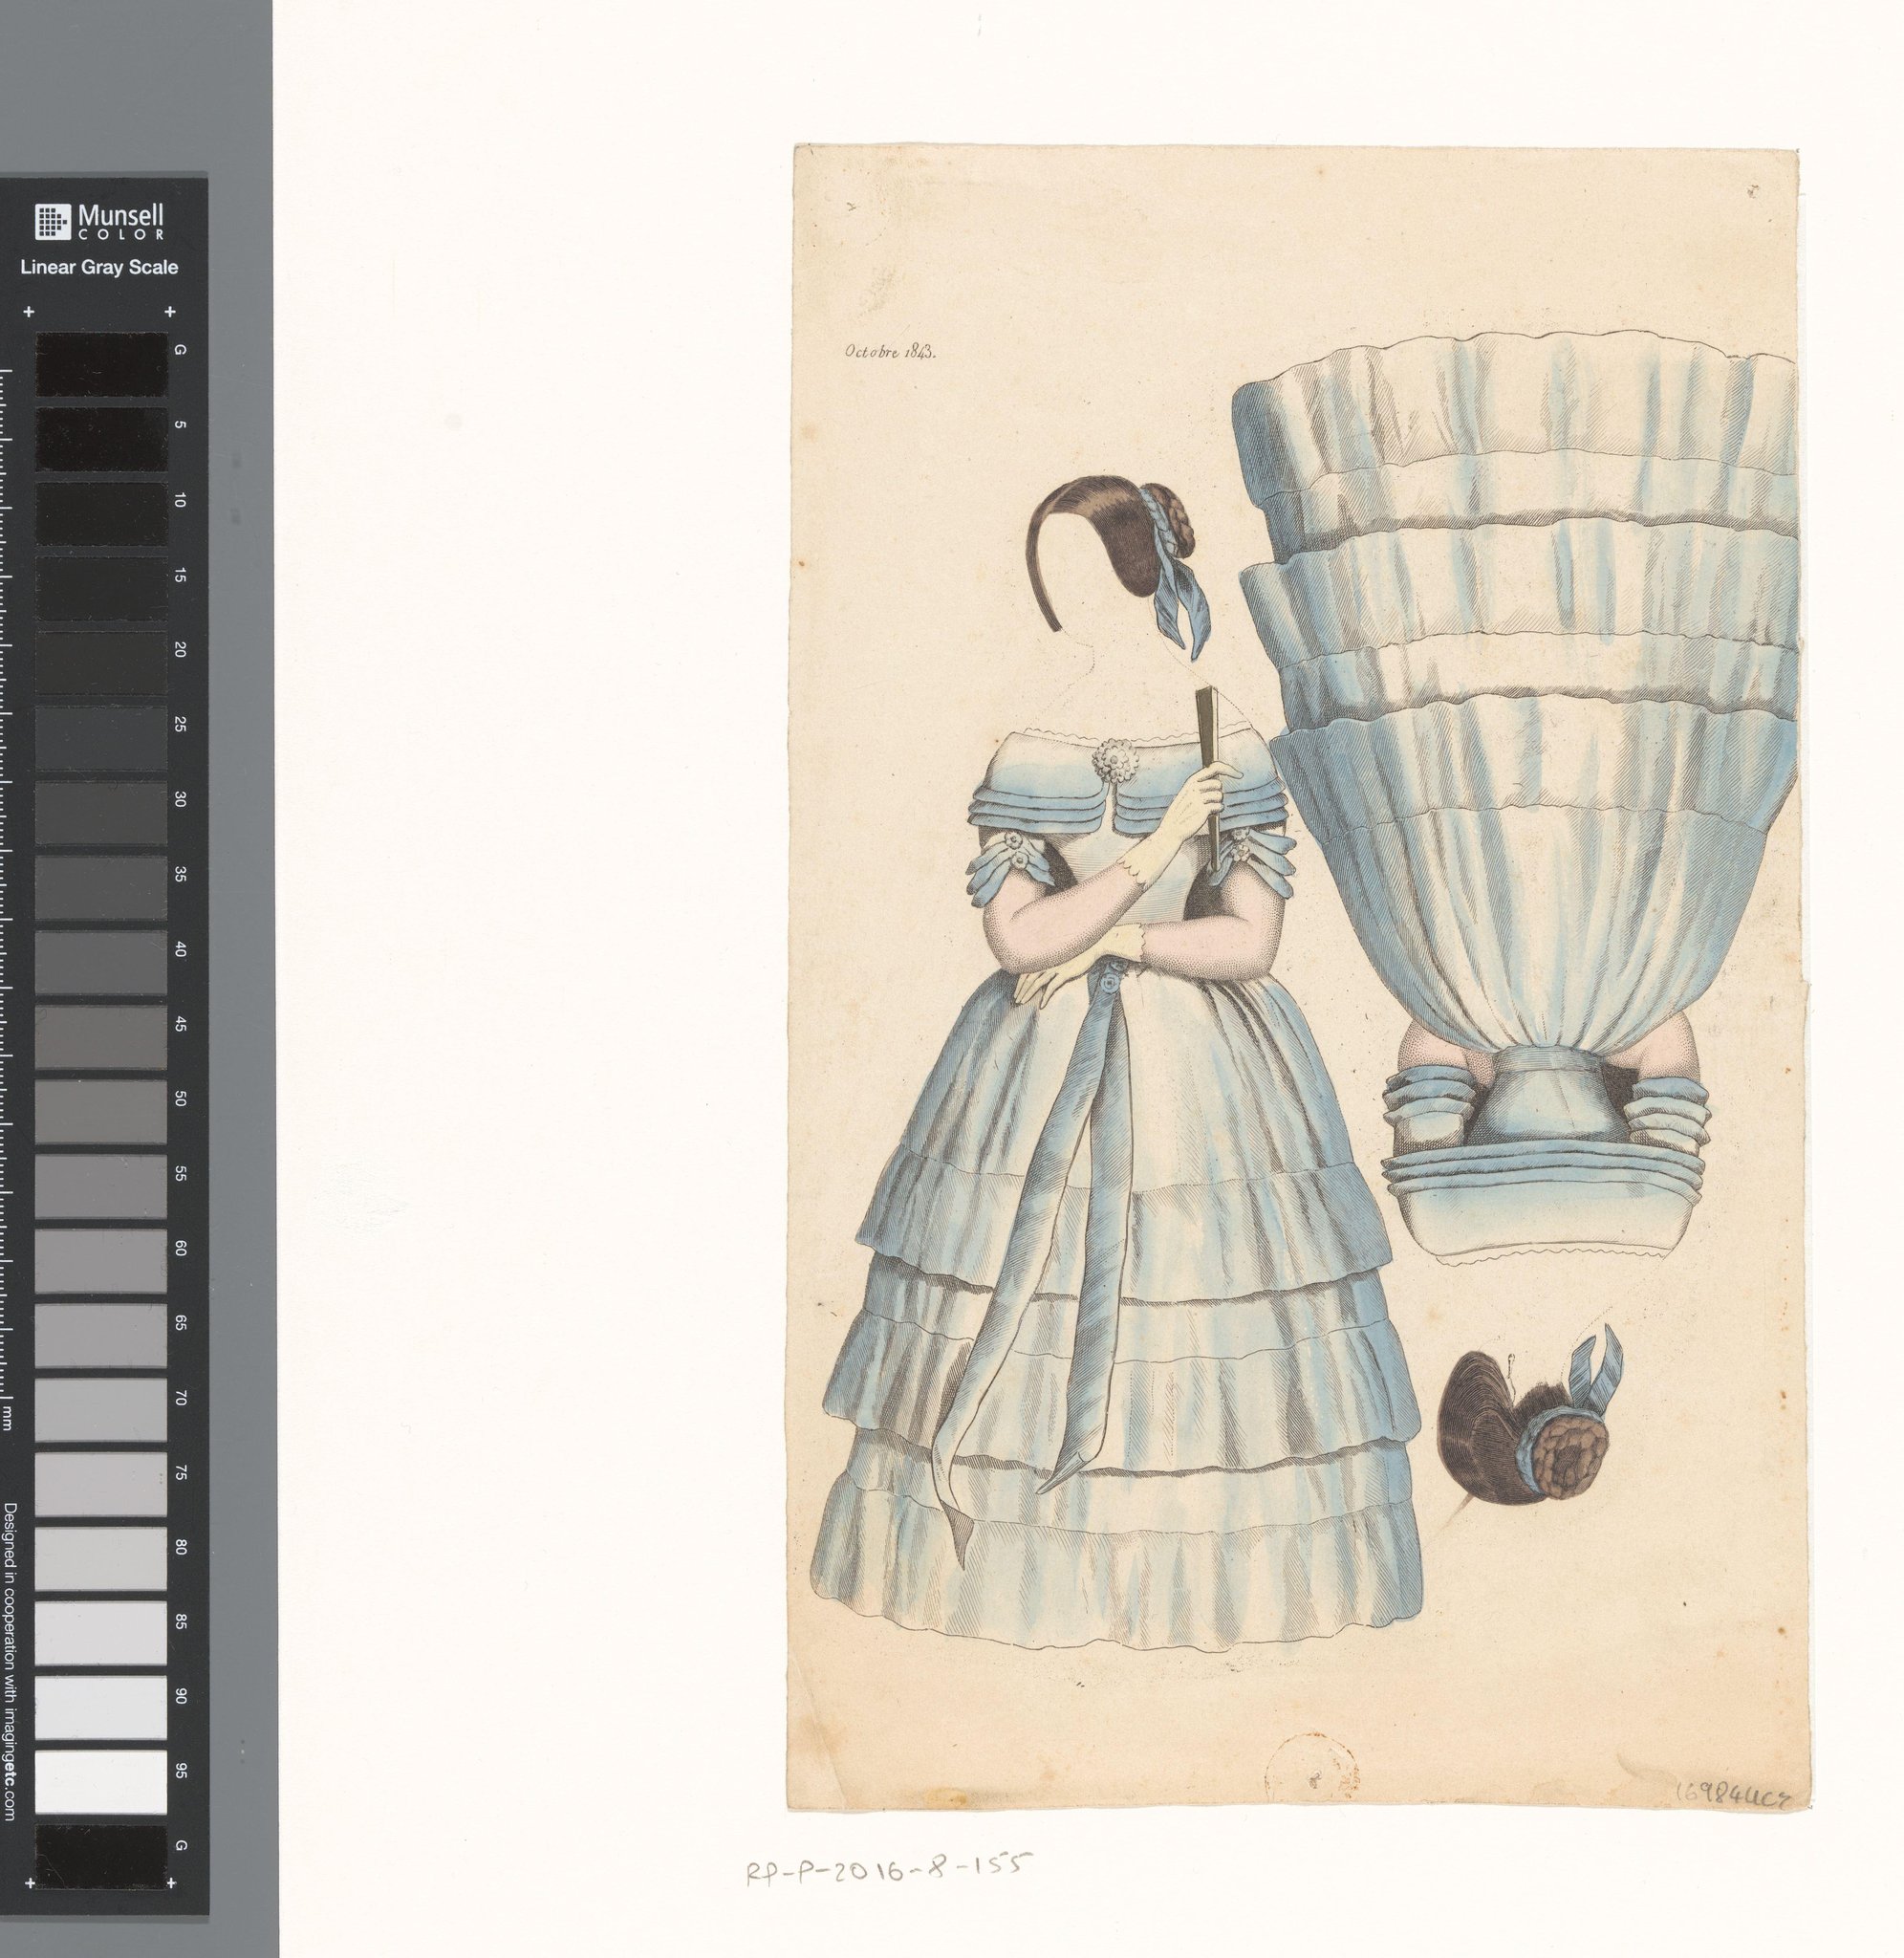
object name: fashion print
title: Uitknippop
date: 1810-1843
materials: paper, ink, watercolor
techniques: etching, hand coloring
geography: europe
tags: fashion plates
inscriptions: collector's mark: Lugt 2228